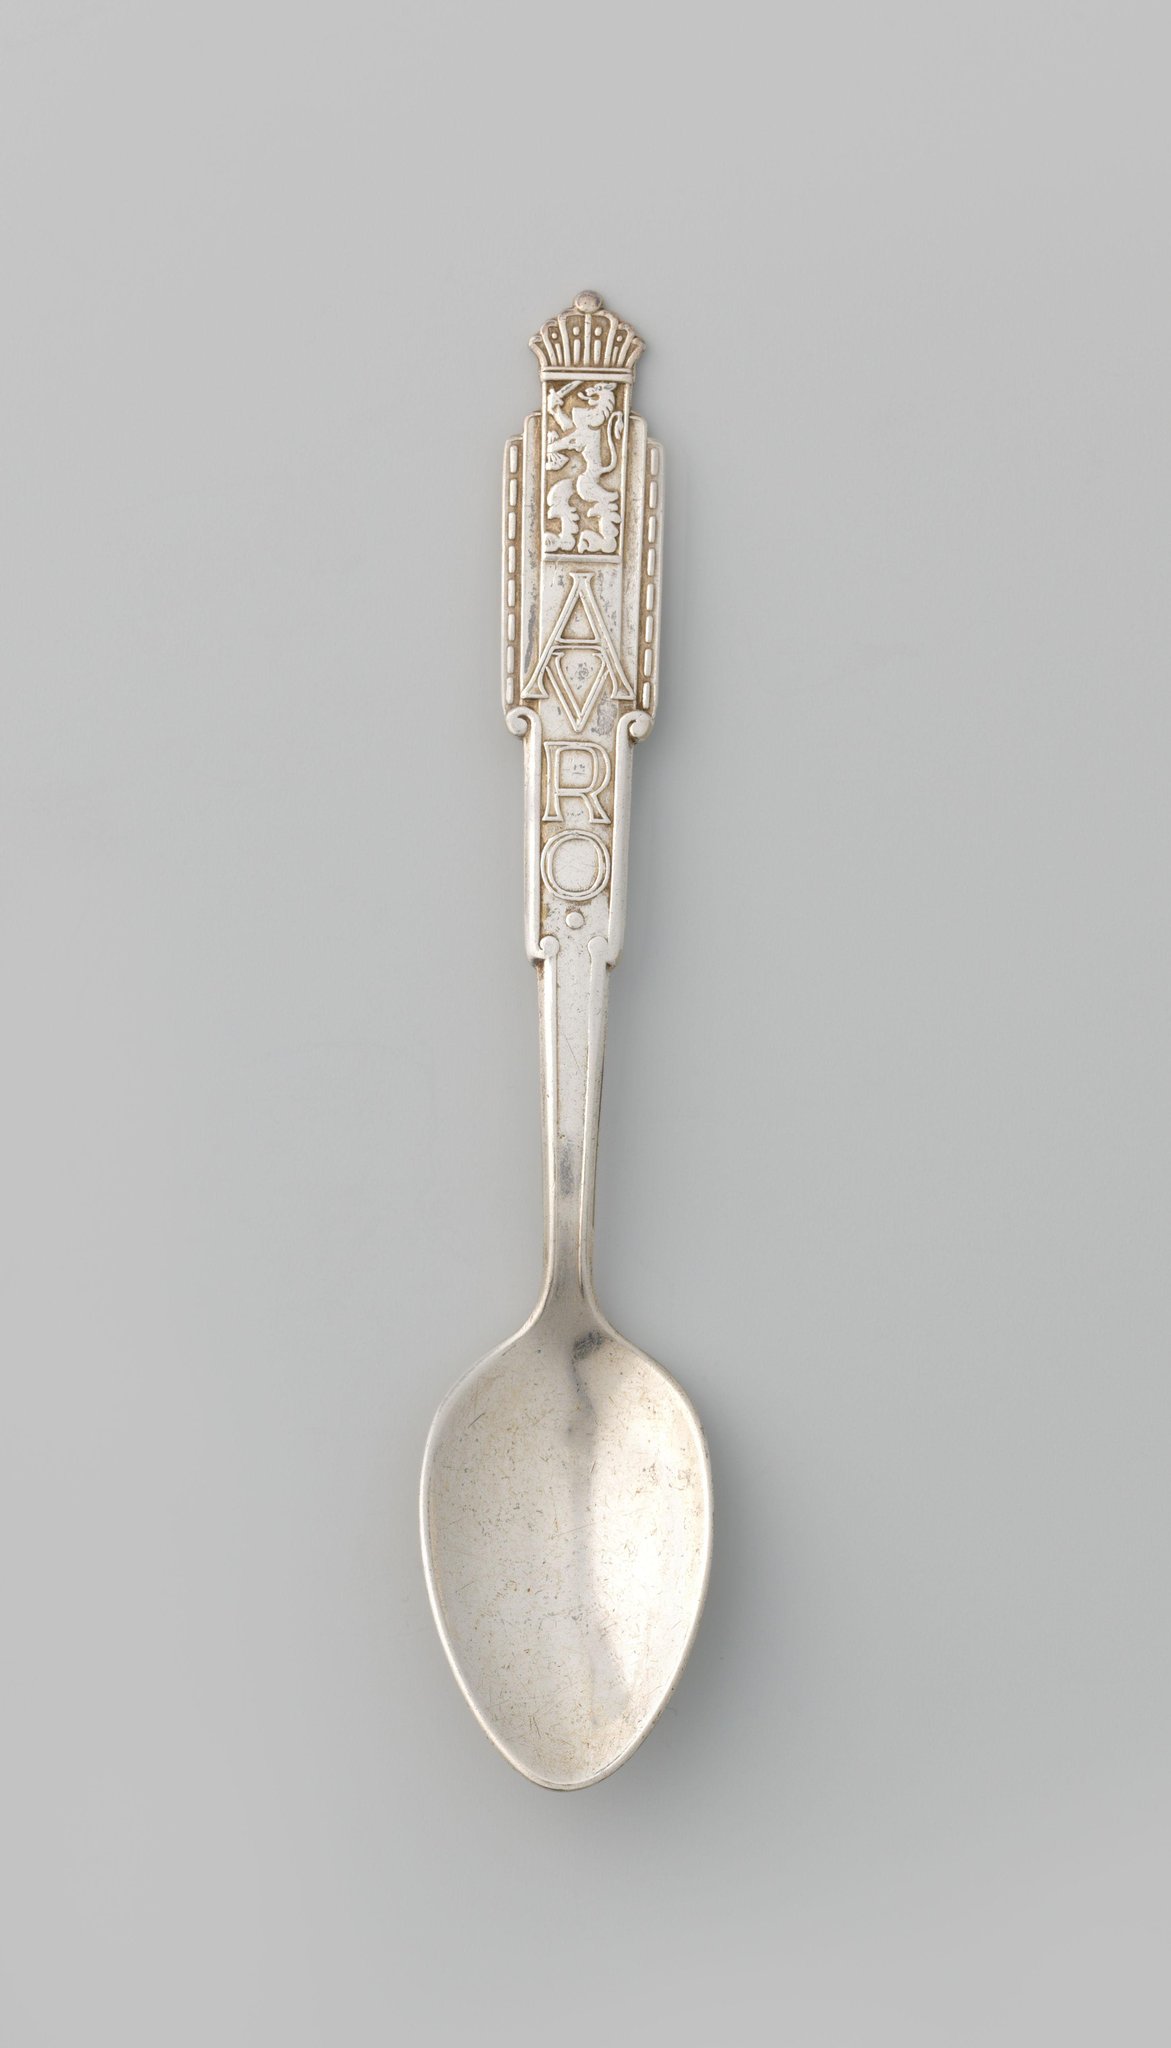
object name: teaspoon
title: Theelepel AVRO, 1932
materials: metal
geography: zeist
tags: netherlands